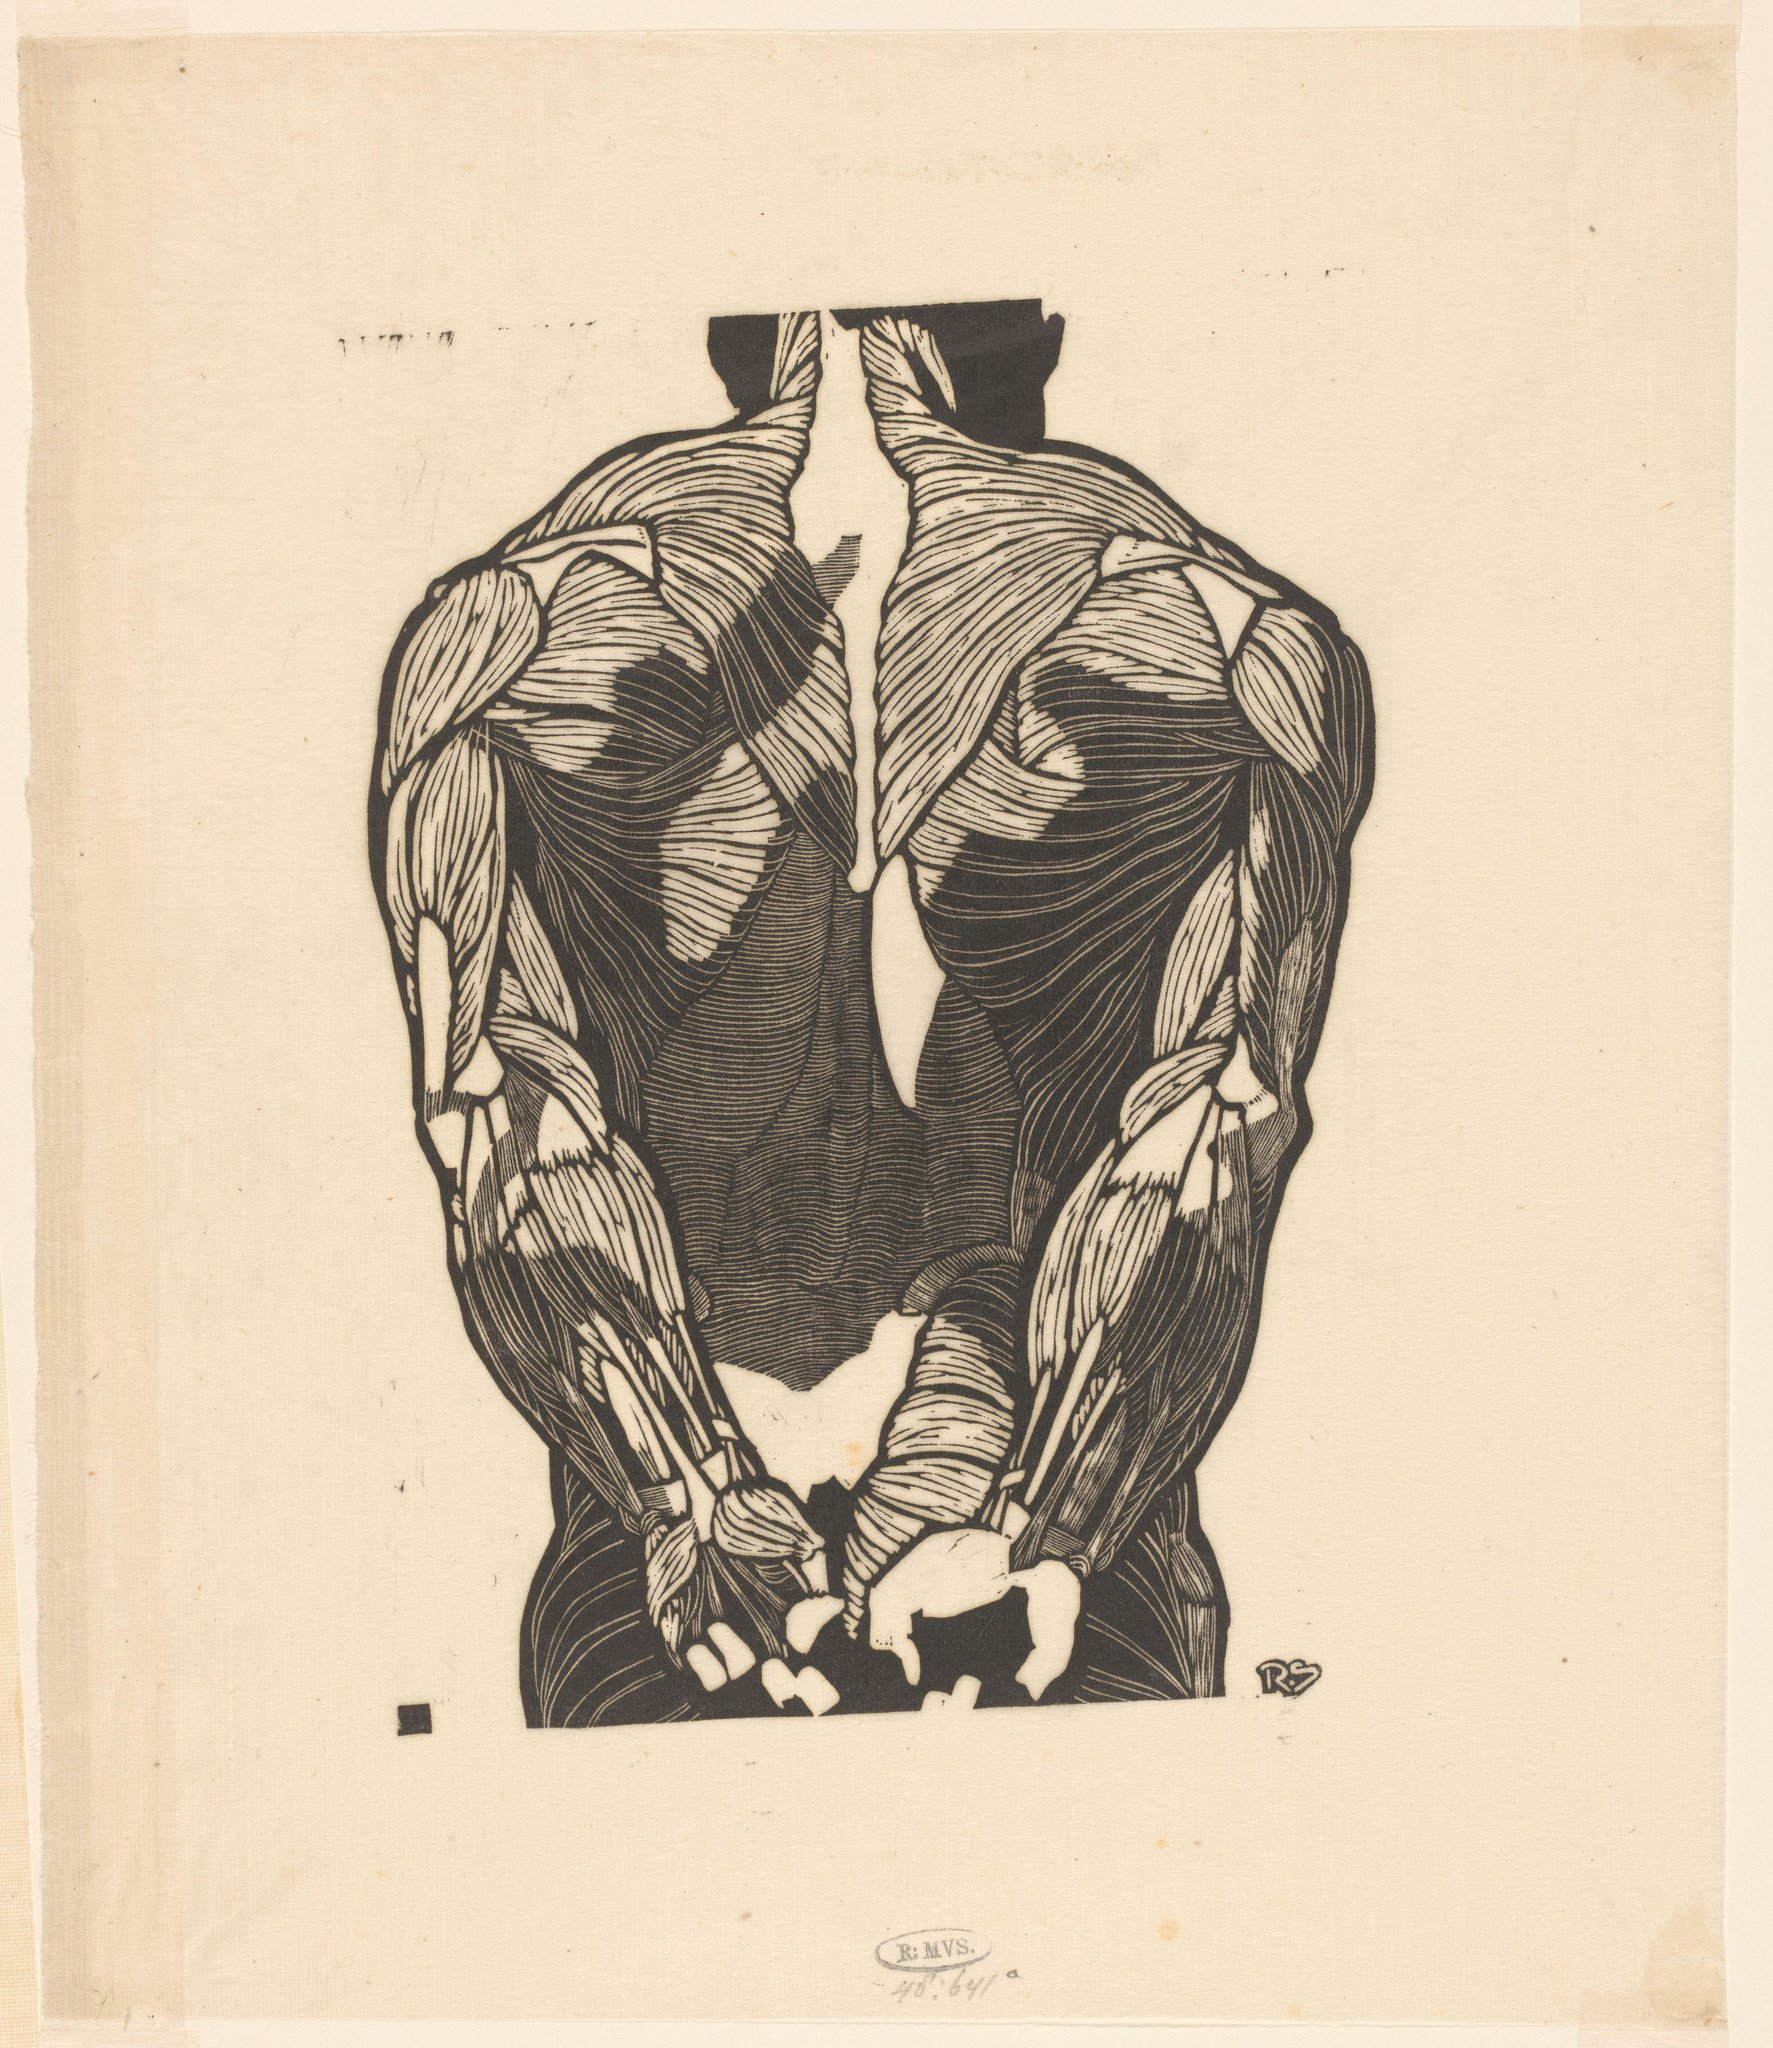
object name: print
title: Anatomische studie van de rugspieren van een man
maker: reijer stolk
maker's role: draughtsman, print maker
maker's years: 1896-1945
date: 1906-1945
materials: paper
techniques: woodcut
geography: netherlands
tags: anatomical model of the muscles, muscle-man, 'écorché'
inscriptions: collector's mark: Lugt 2228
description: Prent gebruikt voor: Stolk, Reyer. Anatomische studies in houtsneden. Amsterdam: G.W. Breughel, 1946, plaat 3.